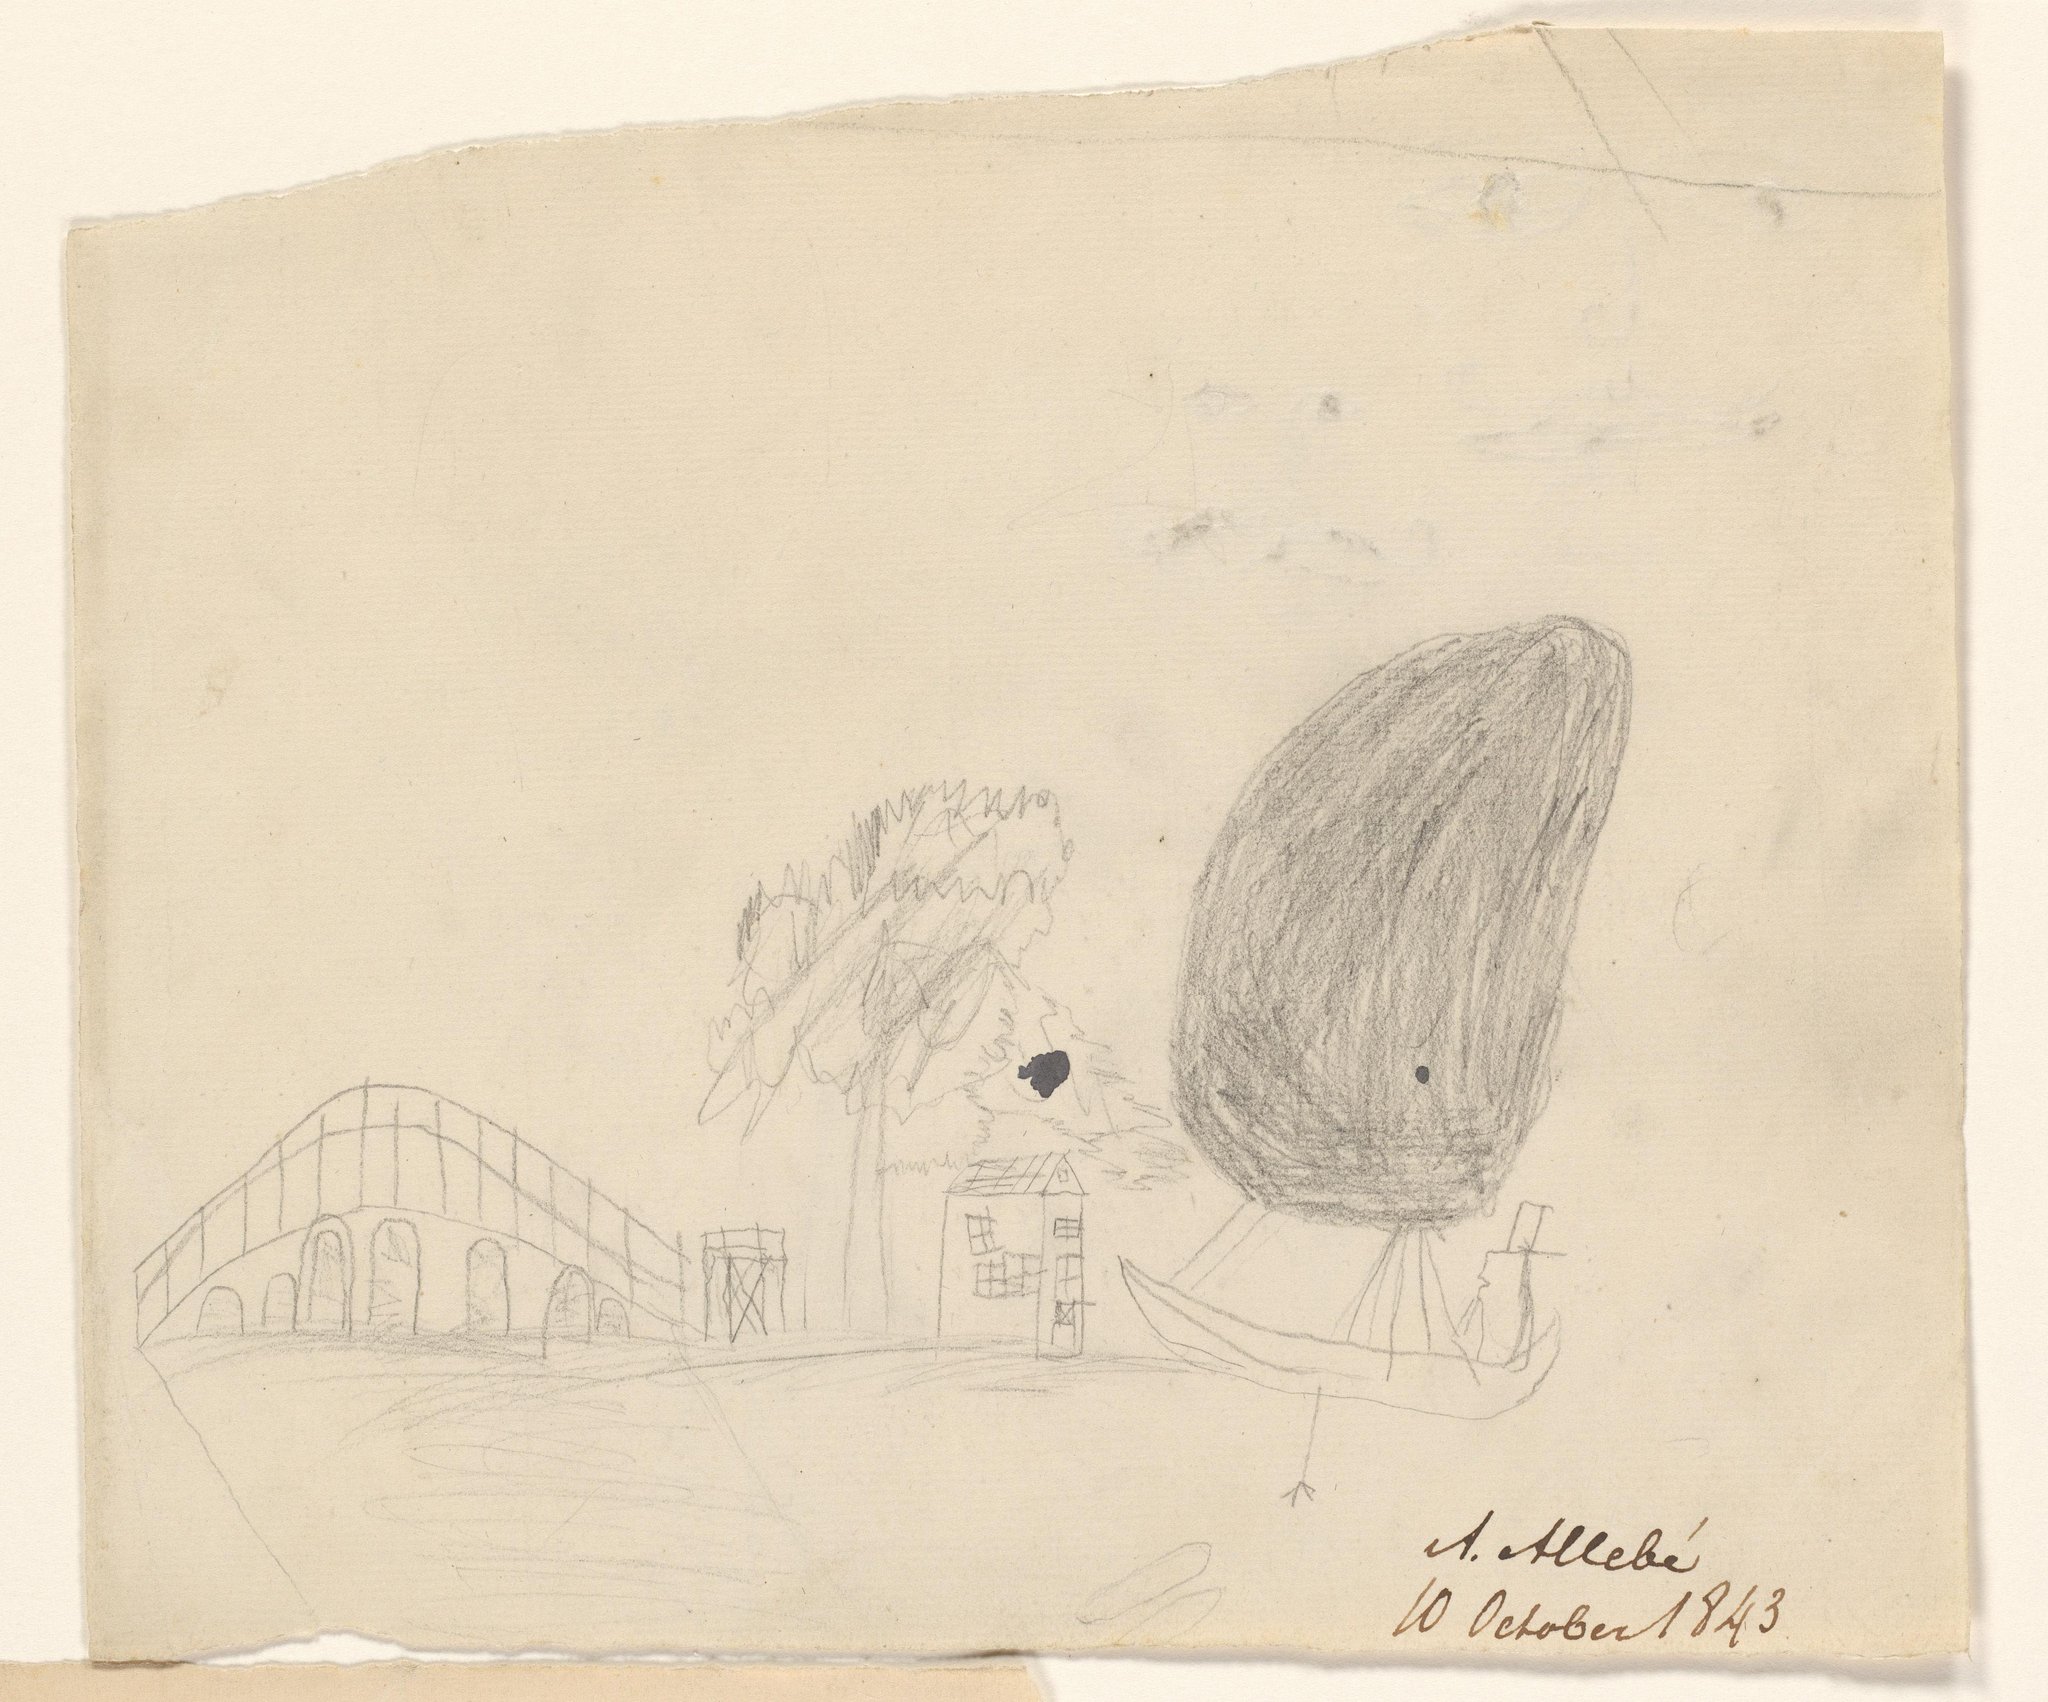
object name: drawing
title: Landschap met zeilschip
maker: august allebé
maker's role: draughtsman, print maker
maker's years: 1838-1927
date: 1843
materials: paper, pencil